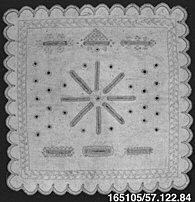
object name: sampler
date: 1801-1900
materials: linen